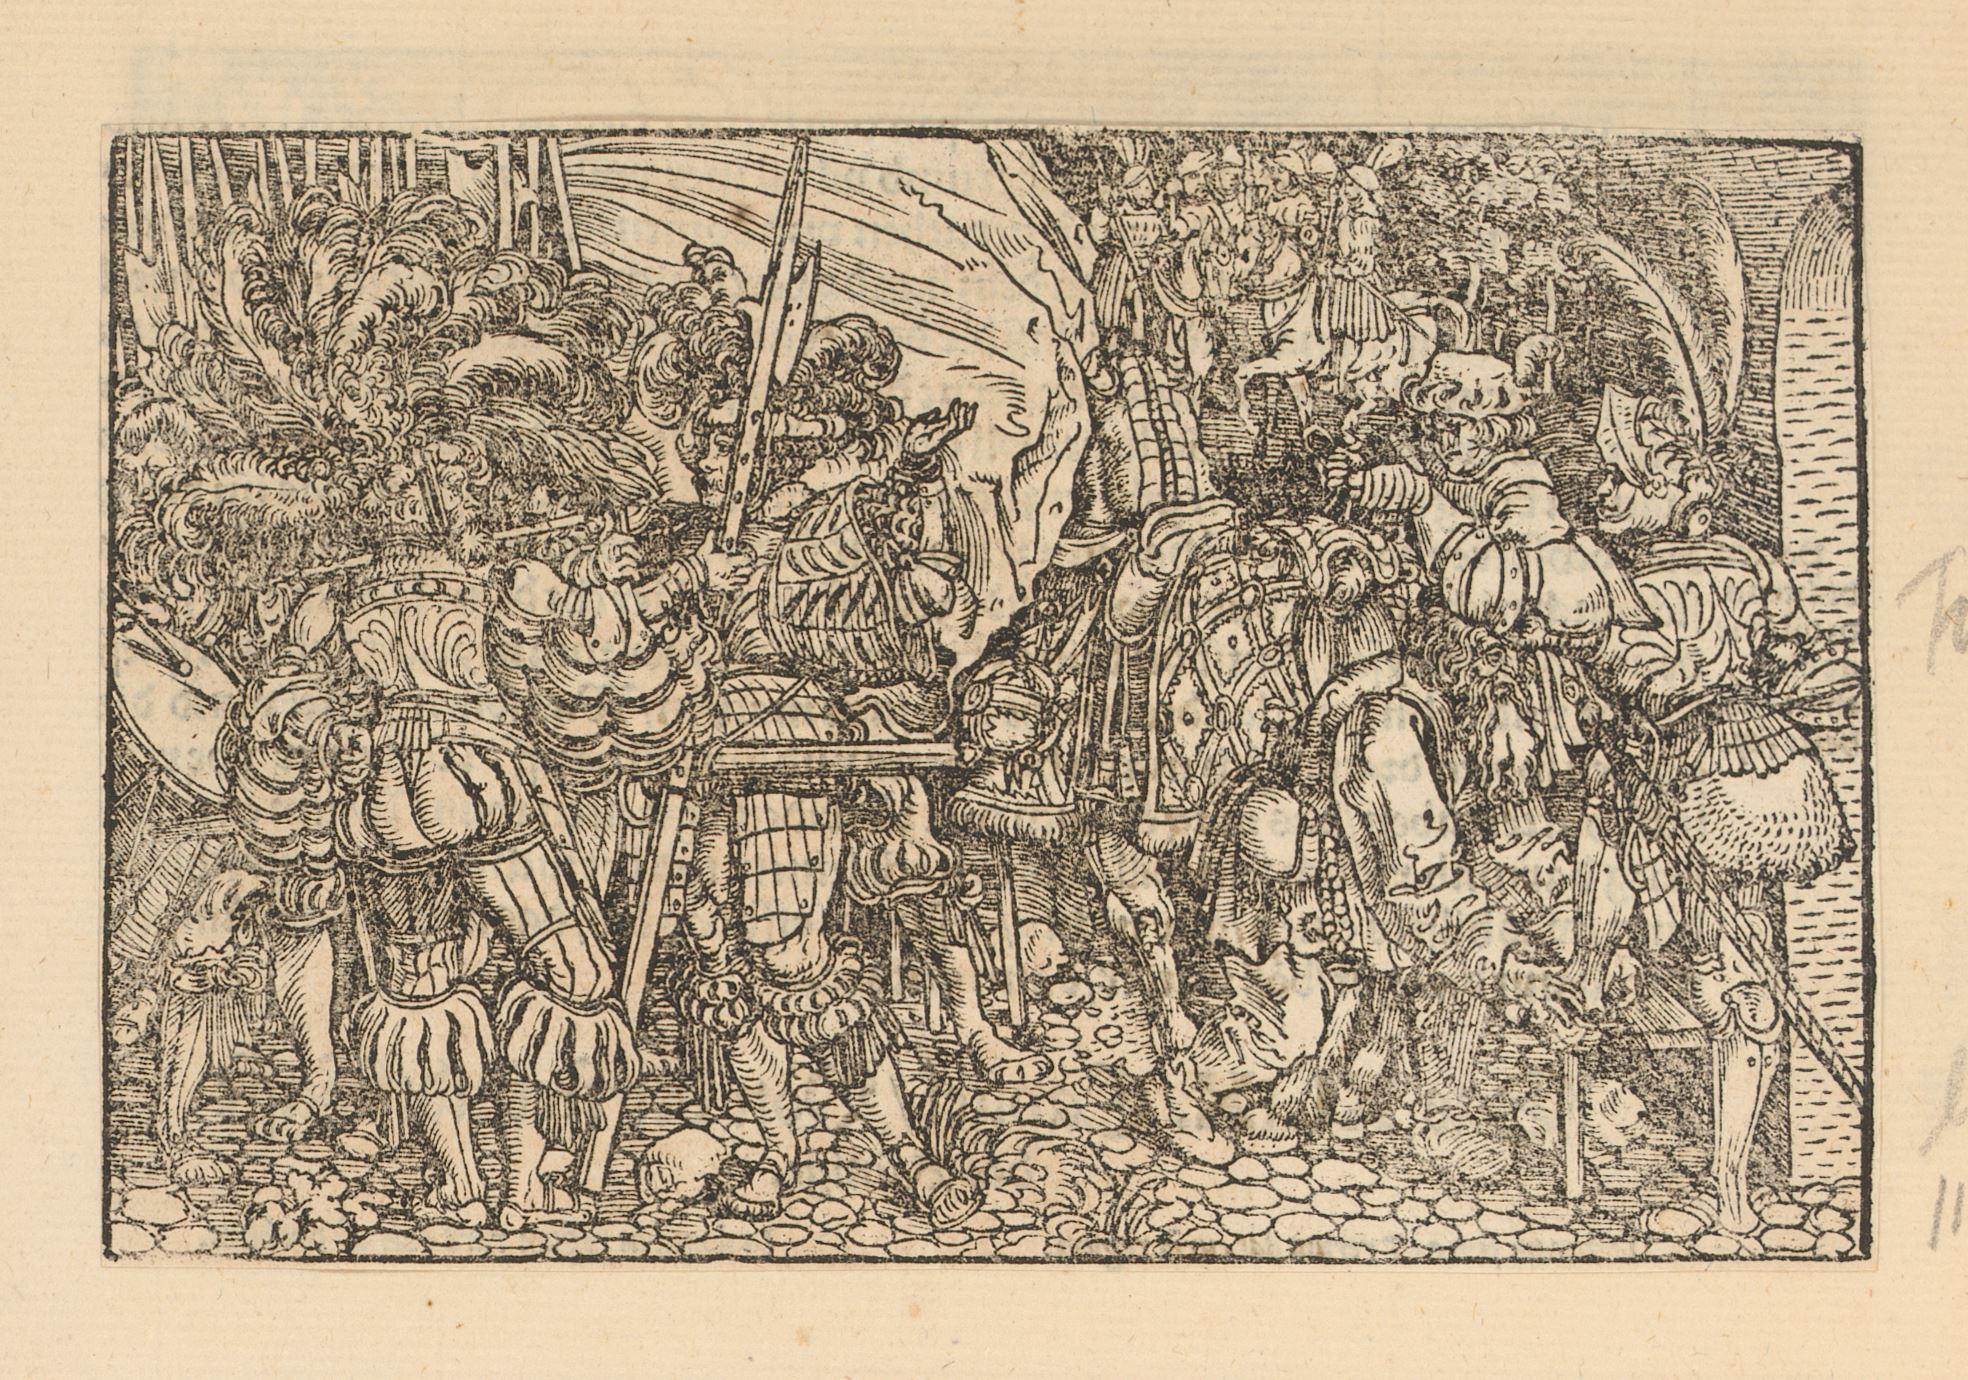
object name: album leaf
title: Ridders en schildknapen die helpen met het aandoen van de sporen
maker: Anonymous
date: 1514-1532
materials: paper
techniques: letterpress printing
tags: shield-bearer, squire, knight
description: Deze prent is gebruikt in: Petrarca, Francesco. Von der Artzney bayder Glück, des guten und widerwertigen: unnd weß sich ain yeder inn Gelück und Unglück halten sol (...). Augsburg: Heinrich Steiner, 1532. Deze uitgave is ook bekend onder de titel 'Trostspiegel in Glück und Unglück'.